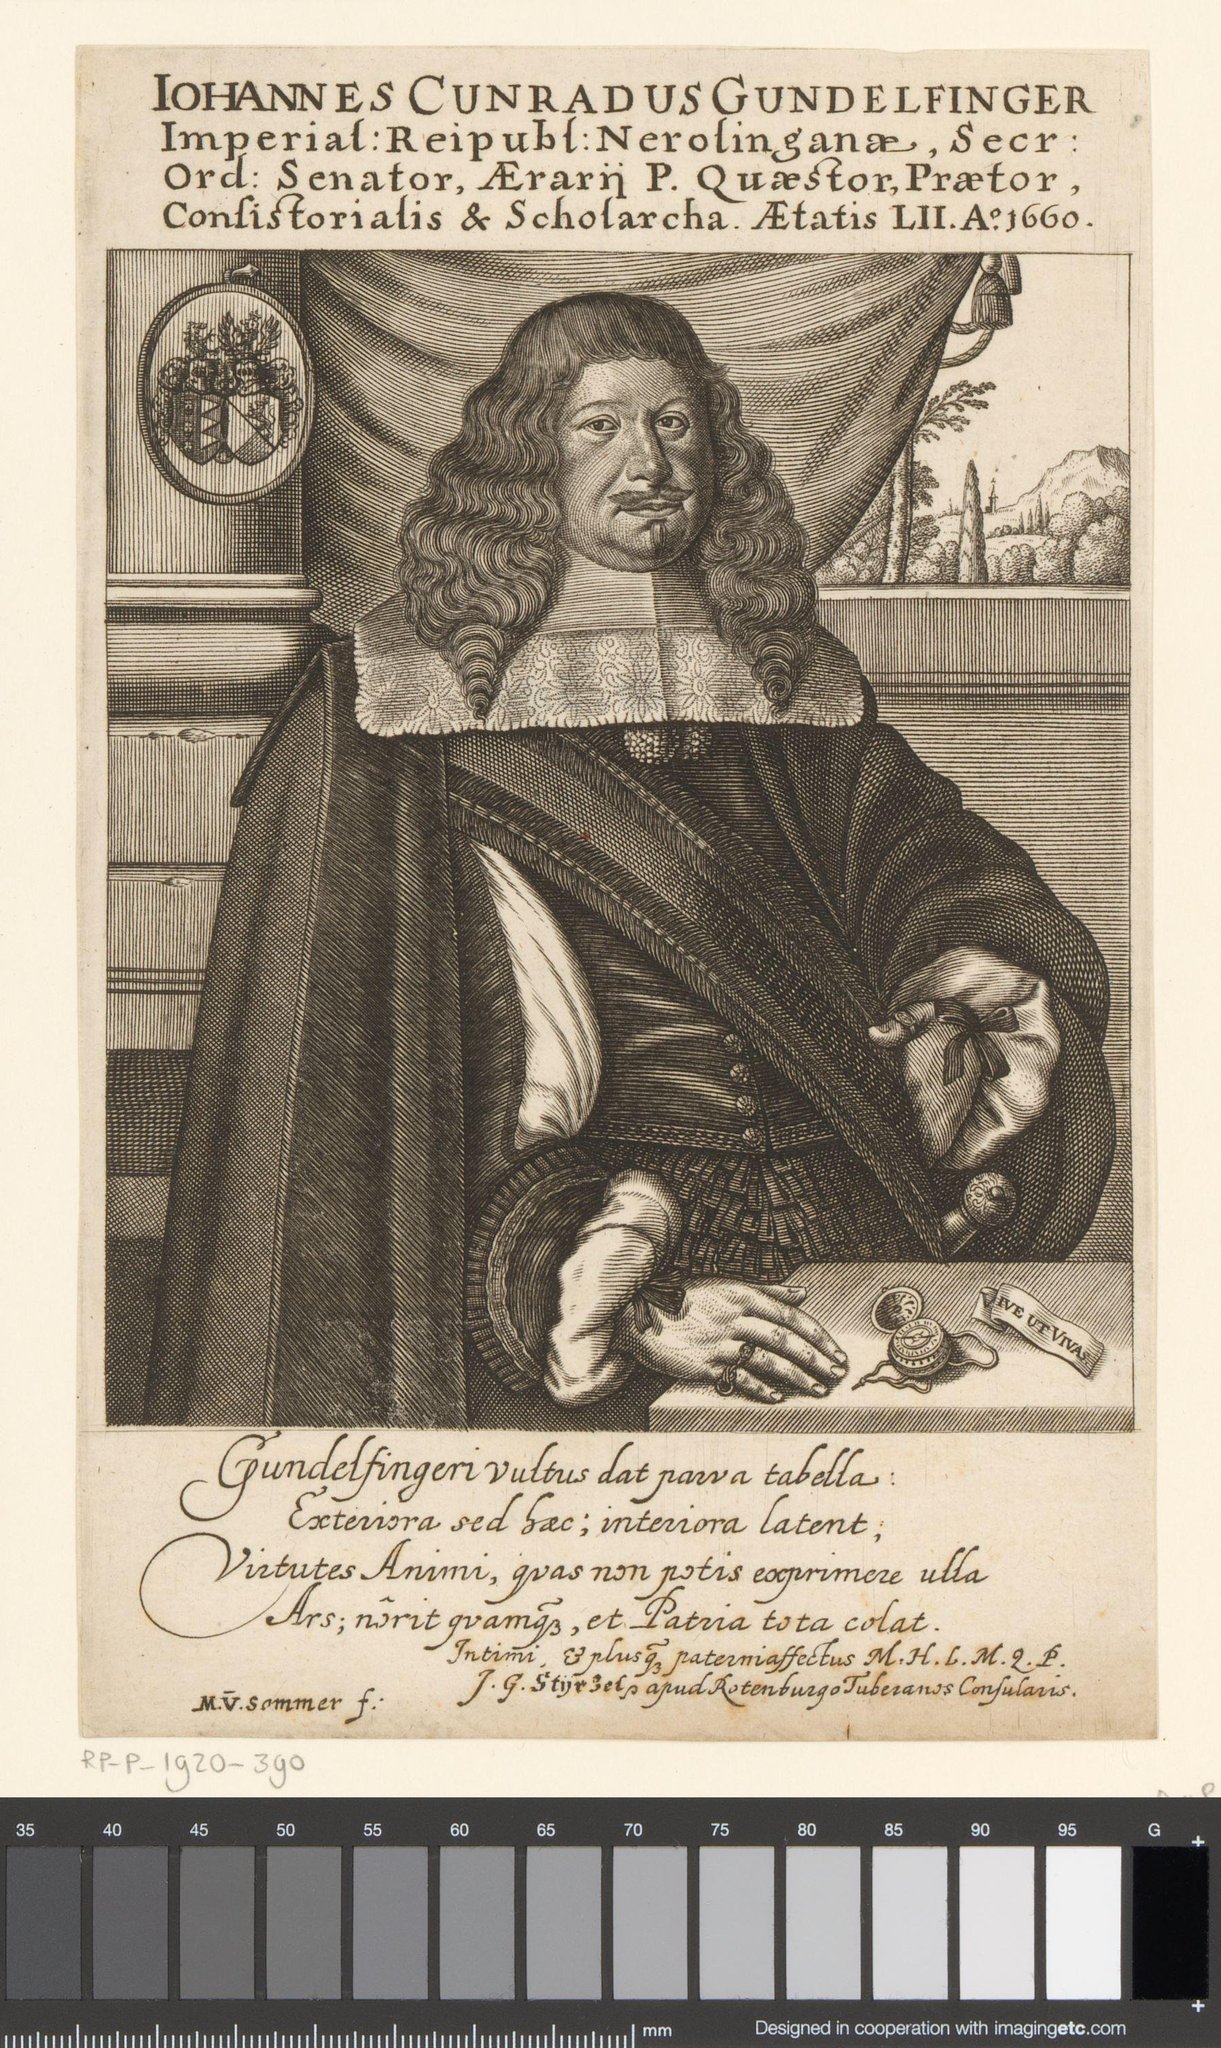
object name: print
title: Portret van Johann Conrad Gundelfinger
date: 1660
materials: paper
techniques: engraving, etching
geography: rothenburg ob der tauber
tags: mayor, historical persons, armorial bearing, heraldry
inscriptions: collector's mark: Lugt 2228